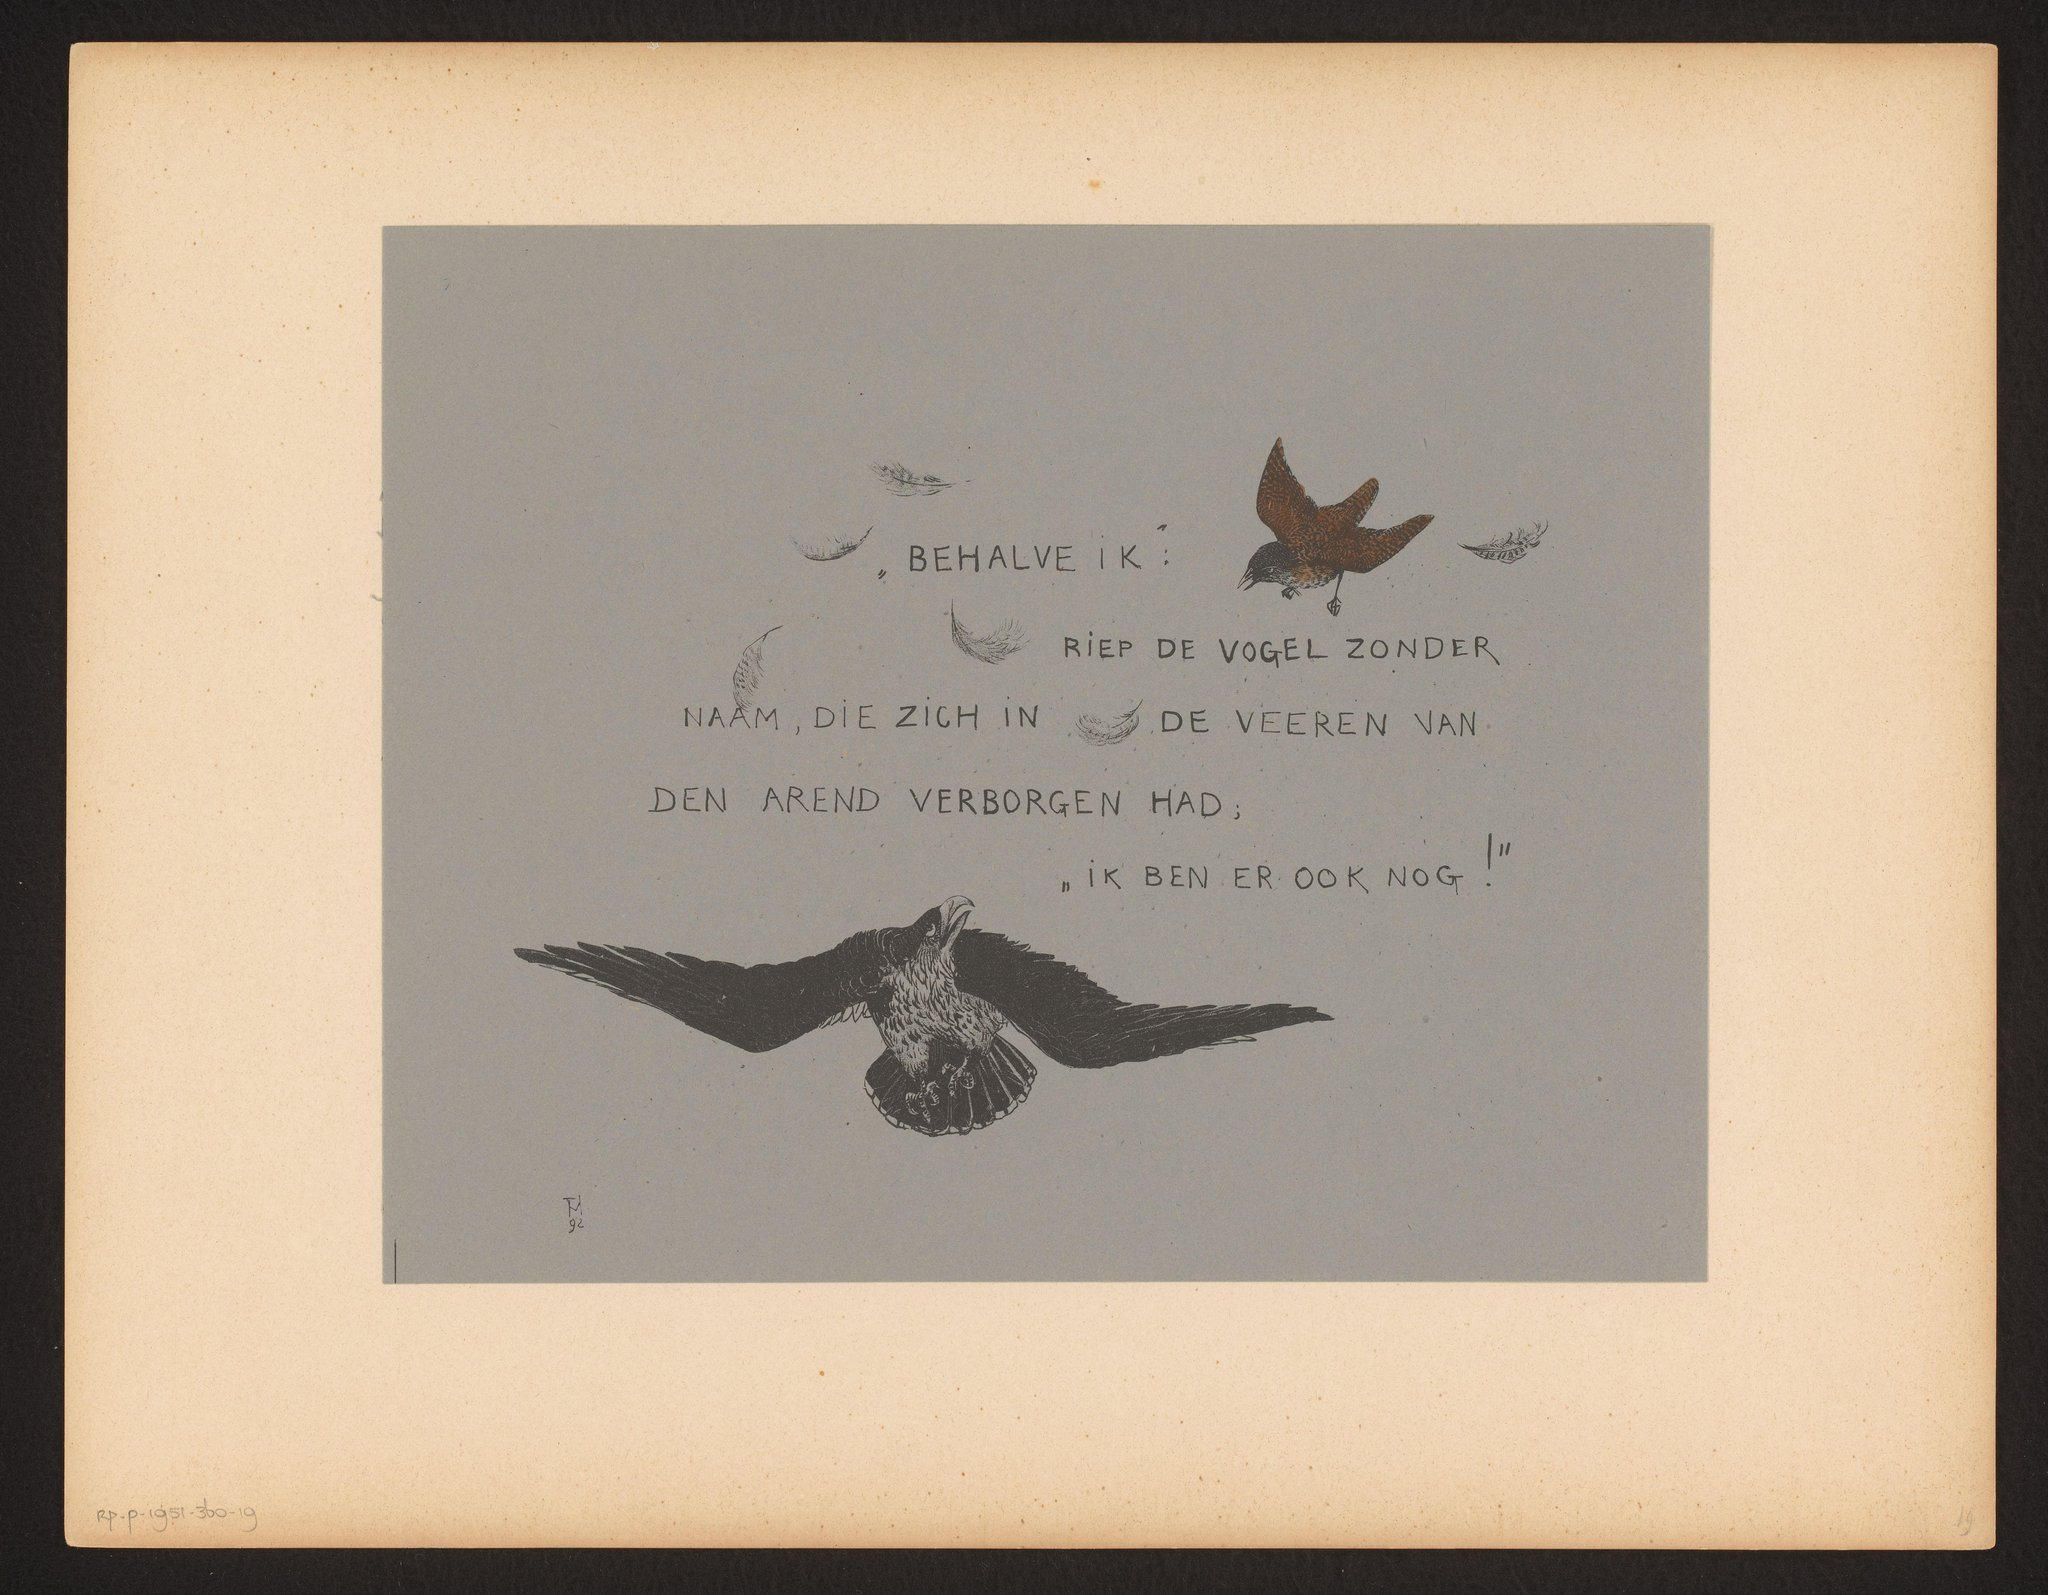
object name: print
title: Hoe de vogels aan een koning kwamen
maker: theo van hoytema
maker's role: draughtsman, painter, print maker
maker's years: 1863-1917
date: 1892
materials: paper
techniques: hand coloring, lithograph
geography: the hague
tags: predatory birds: eagle, song-birds: wren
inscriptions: date